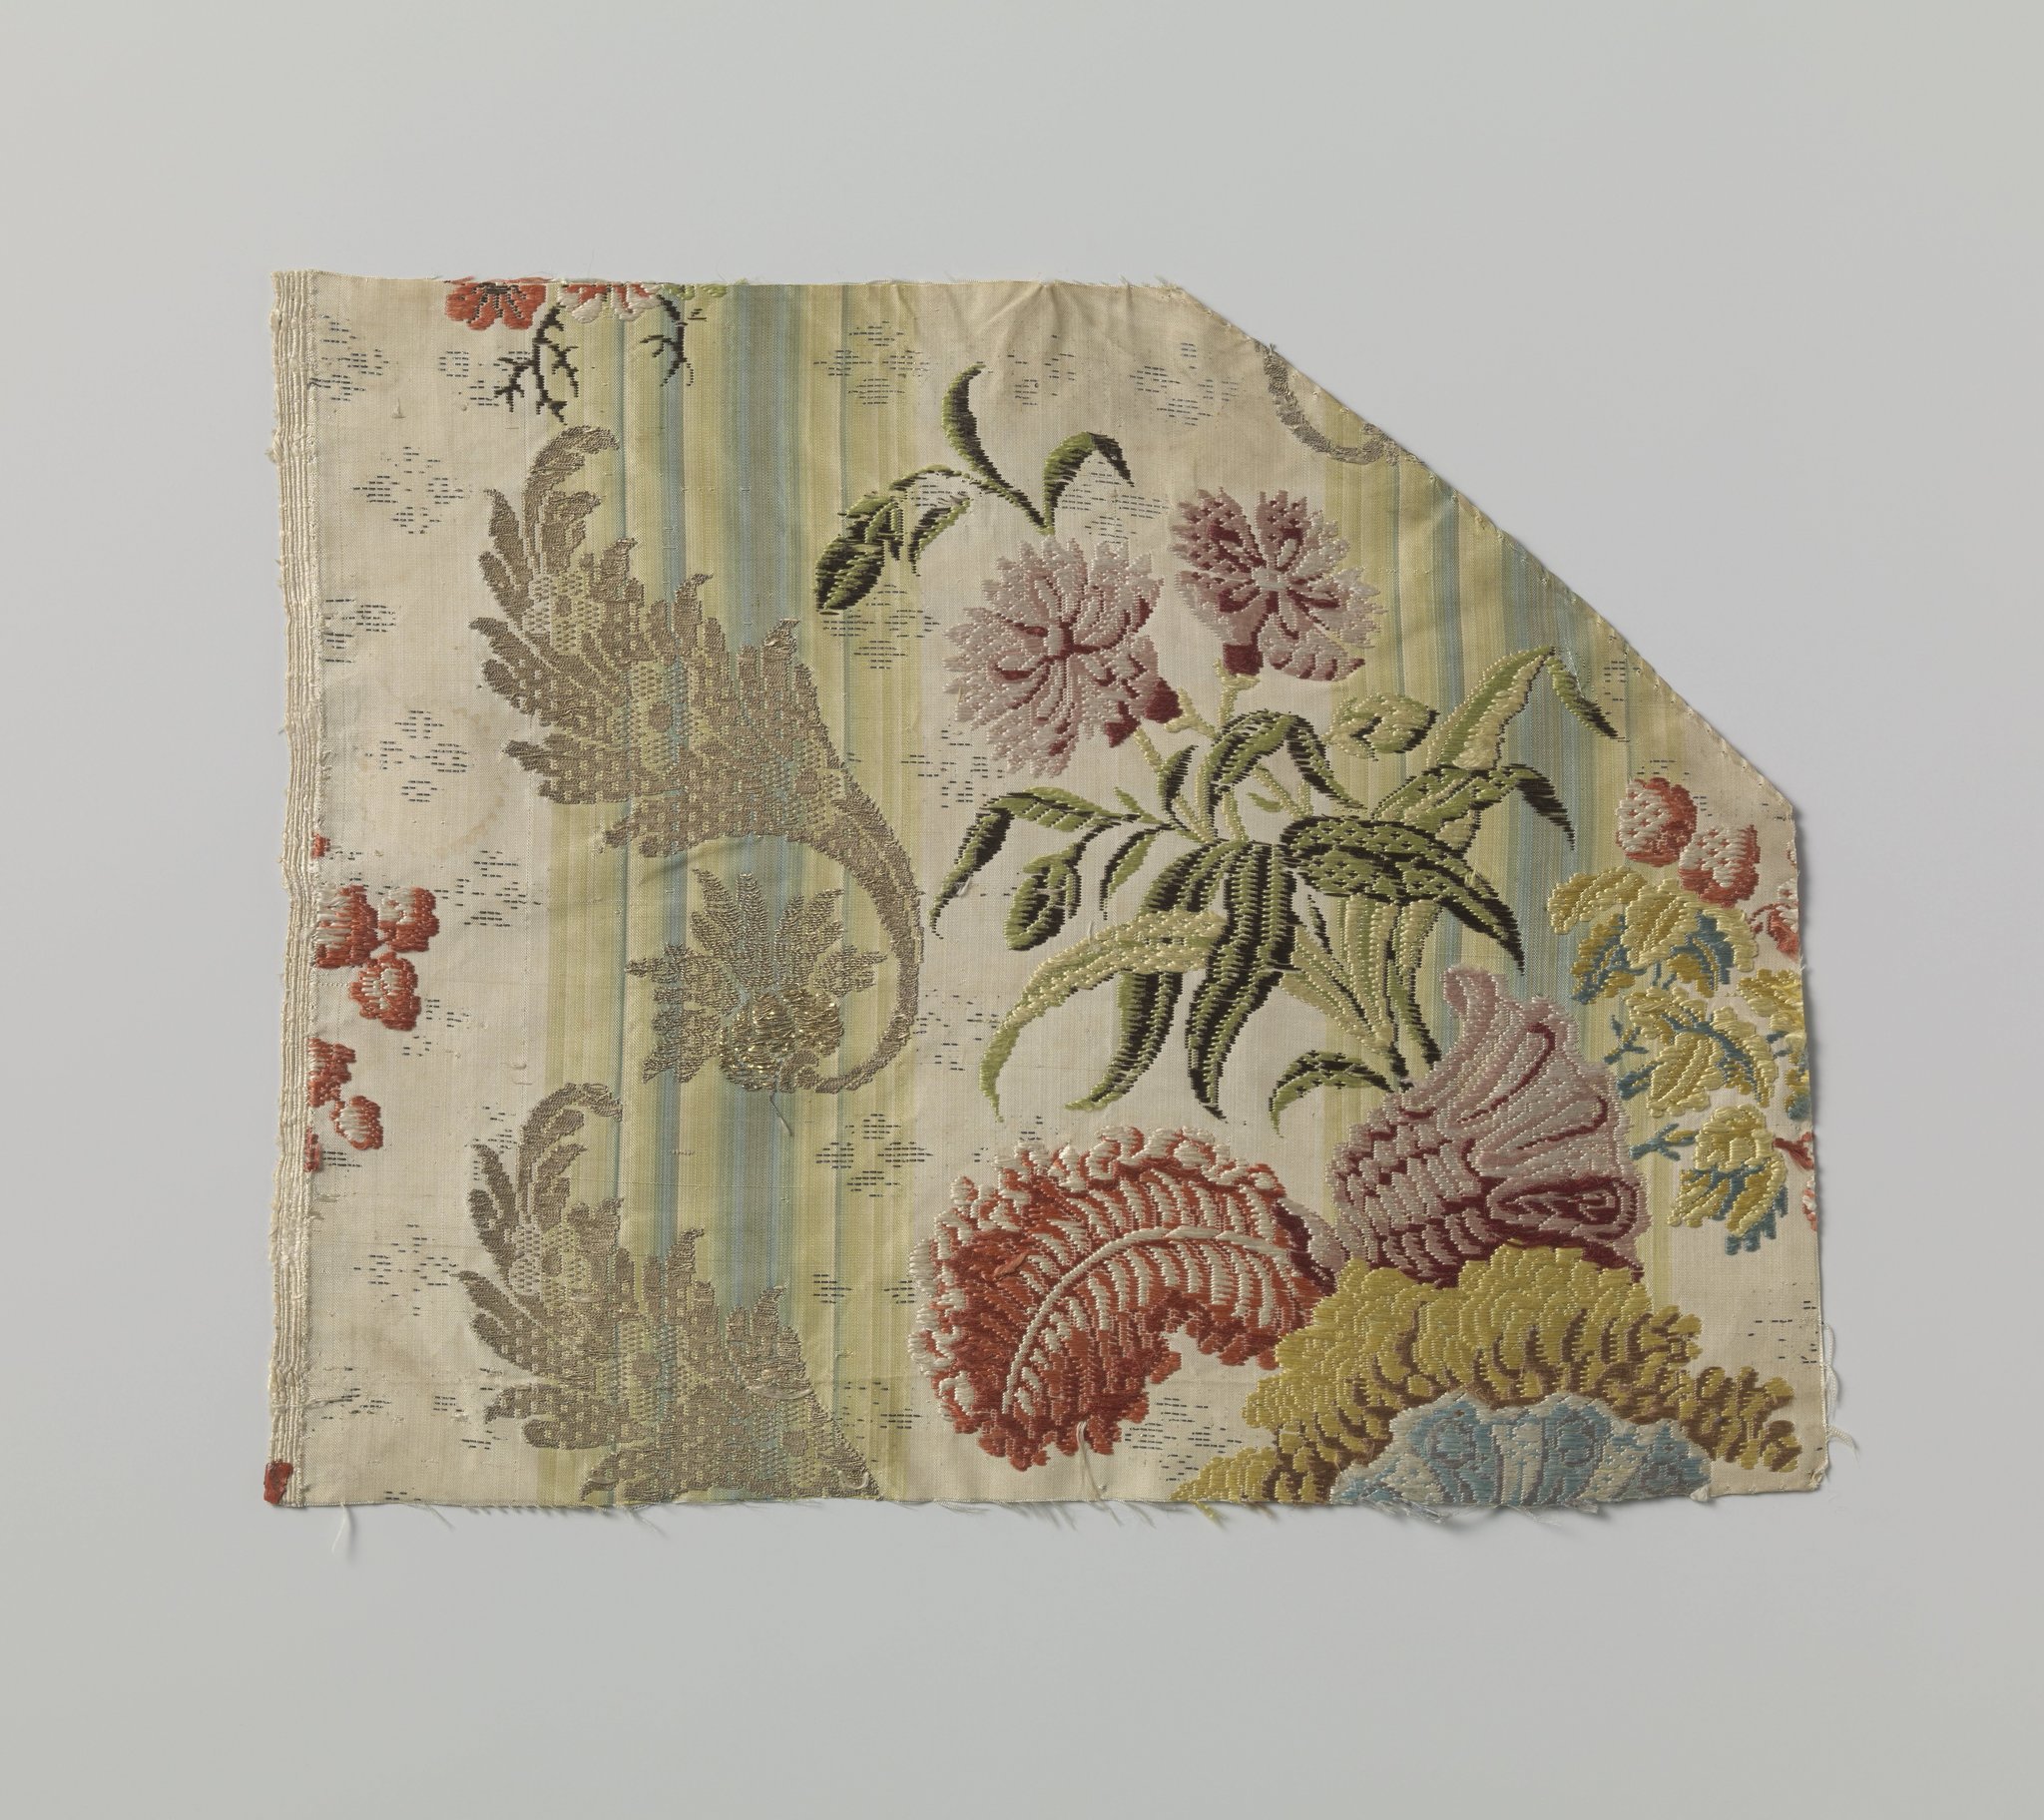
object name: fragment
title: Fragment veelkleurig gebrocheerde zijde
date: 1730-1800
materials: silk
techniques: brocade, weave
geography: netherlands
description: Een fragment van witte zijde, grond met groene banden, waarover bloemen van paarse groen, zwart gele zijde, figuren van gouddraad. Opmerking: Zelfkant; grove kettinggarens (6).